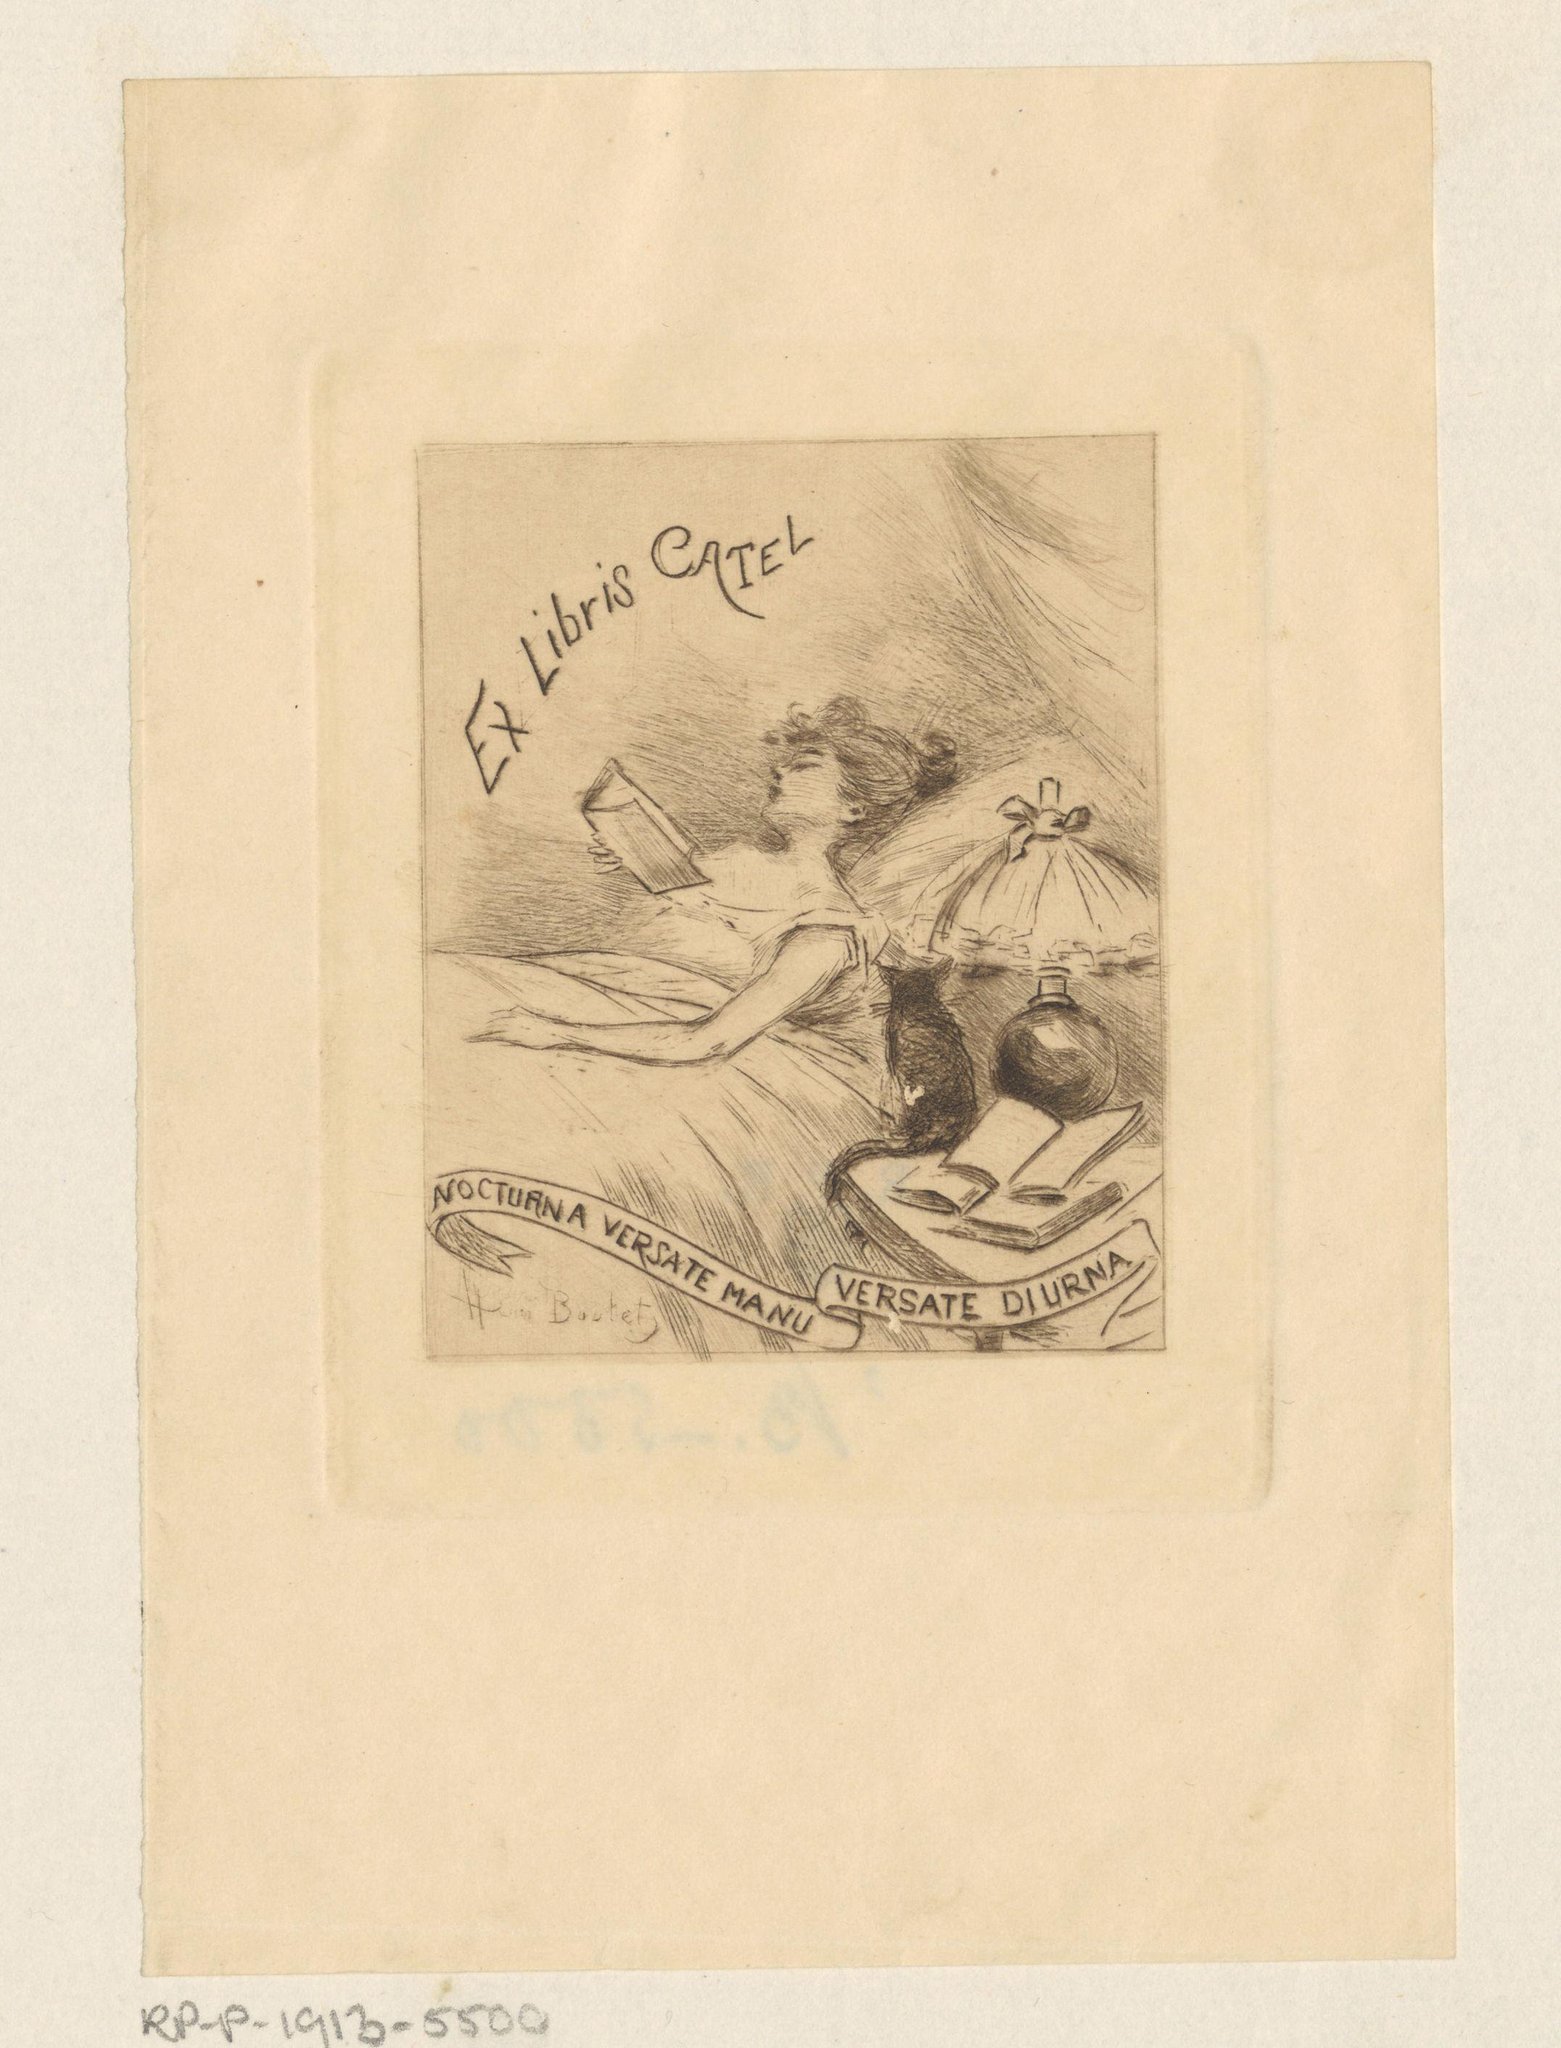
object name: bookplate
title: Ex libris van Catel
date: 1861-1910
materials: paper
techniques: etching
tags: reading, cat, bed, lying figure - aa - female human figure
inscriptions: collector's mark: Lugt 2760, collector's mark: Lugt 2233